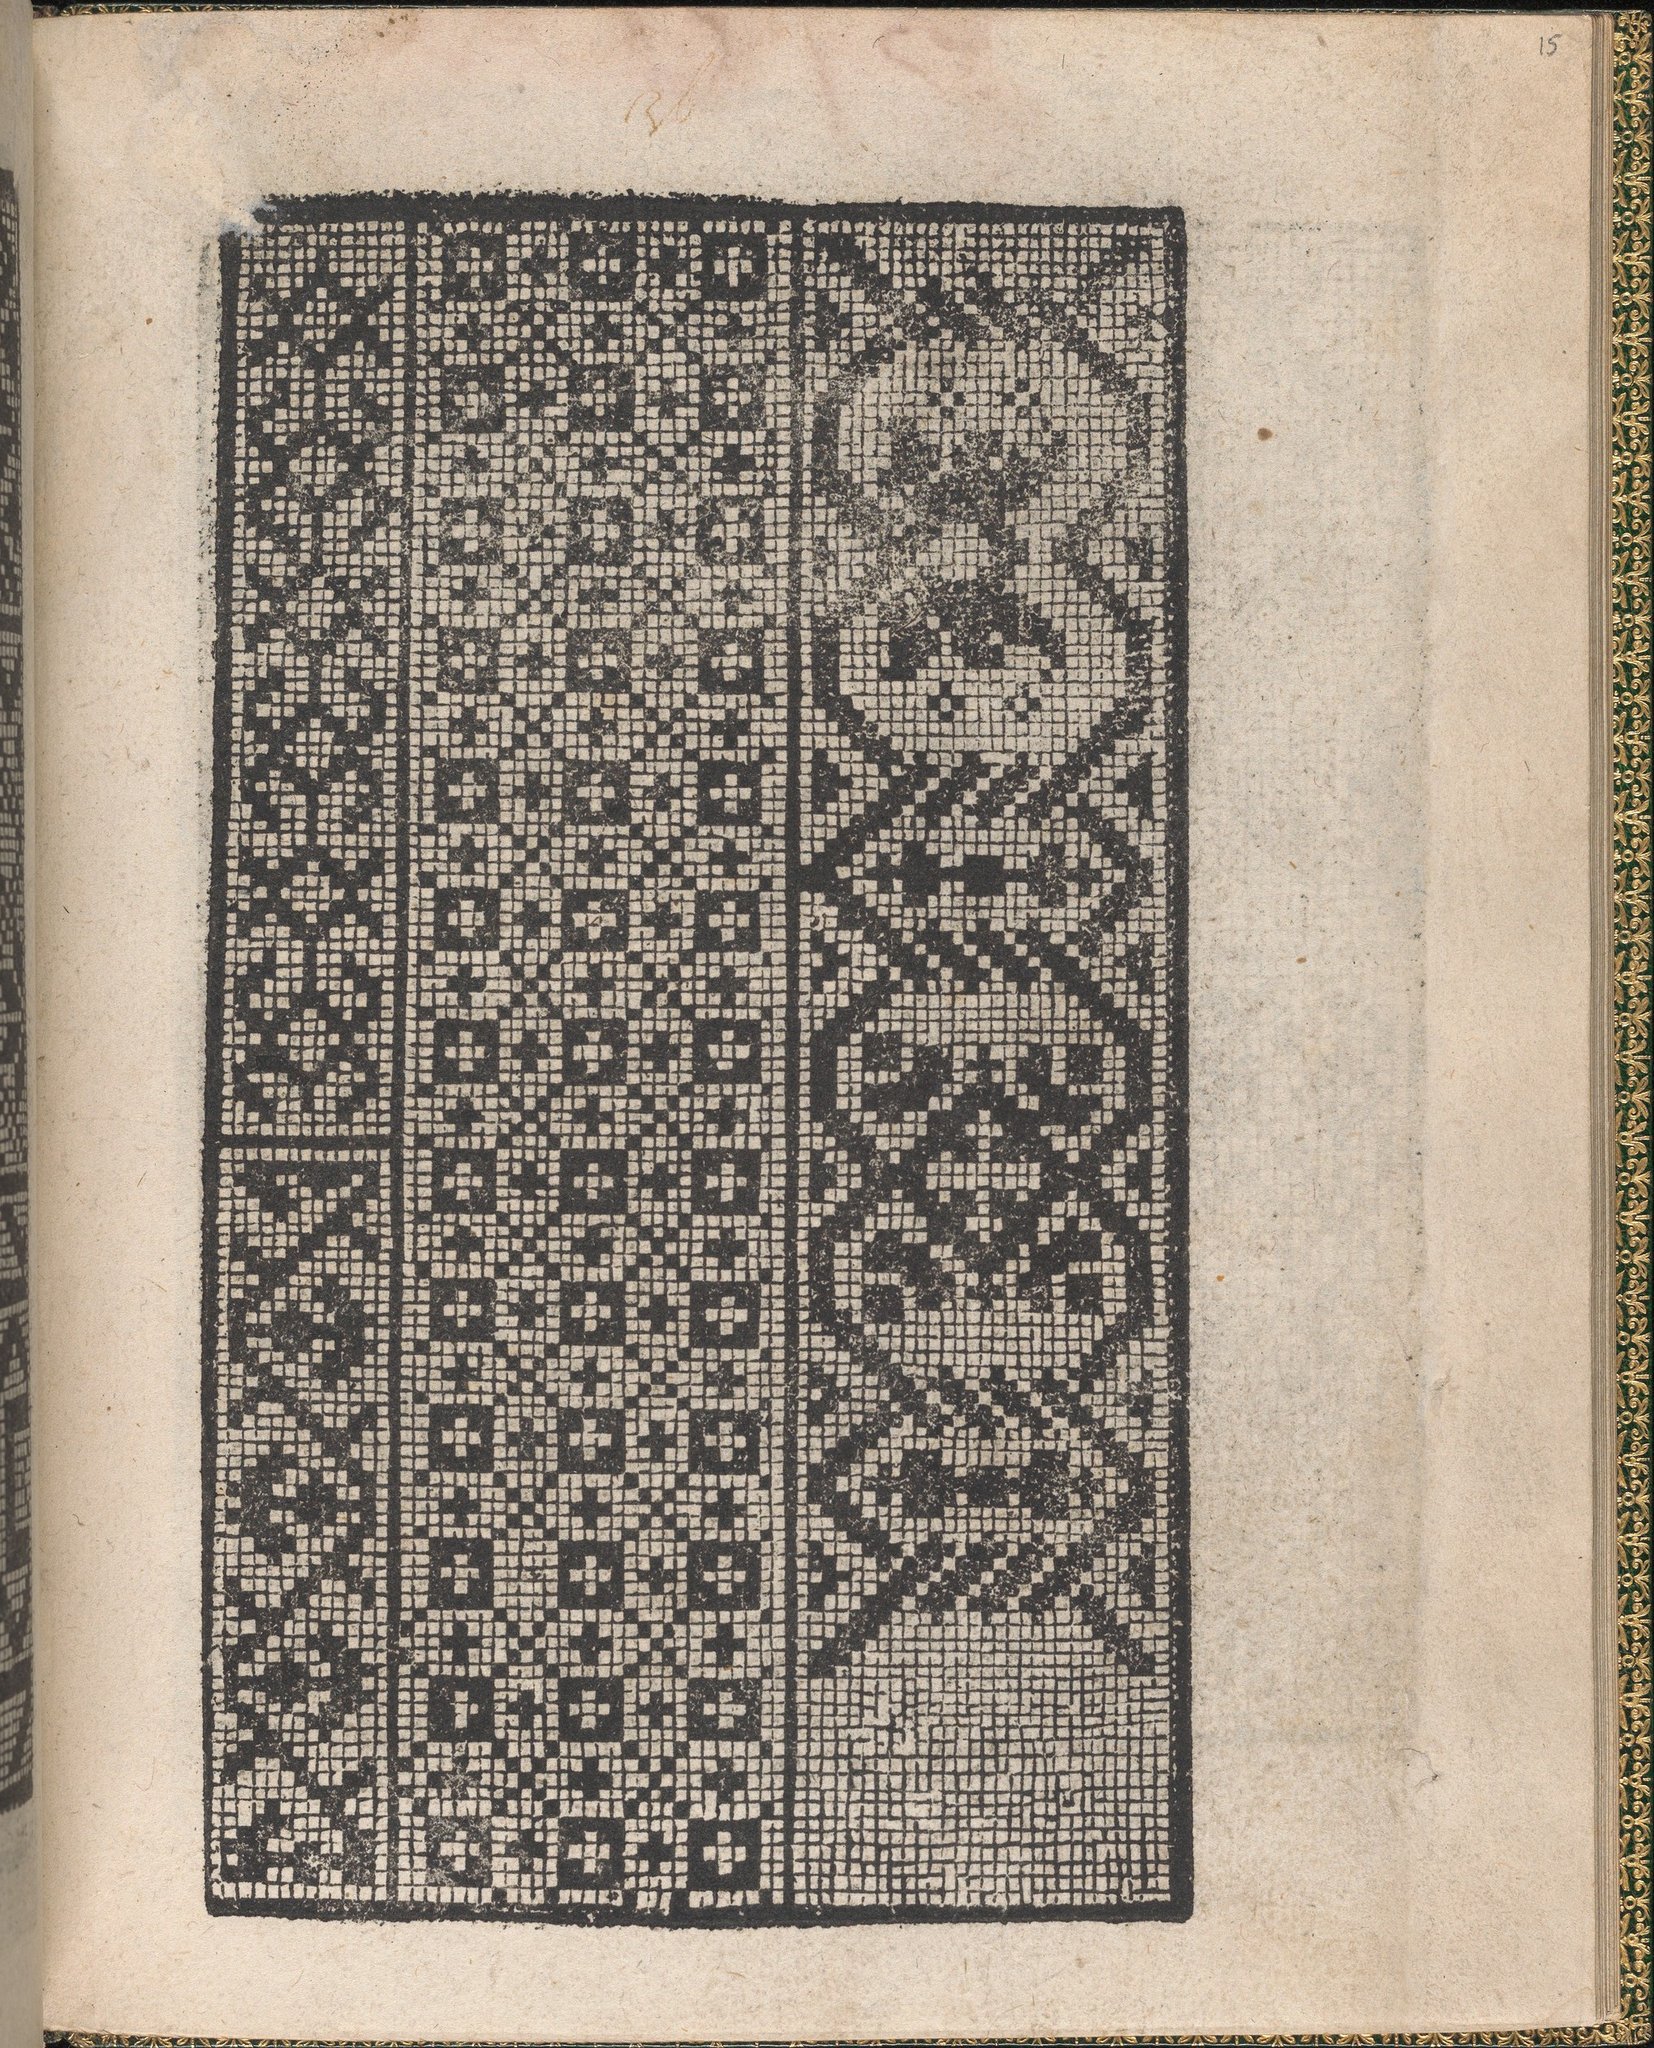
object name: book print ornament architecture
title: Ornamento delle belle & virtuose donne, page 8 (verso)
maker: matteo pagano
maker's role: publisher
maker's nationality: italian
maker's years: 1515-1588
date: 1554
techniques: woodcut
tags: ornament